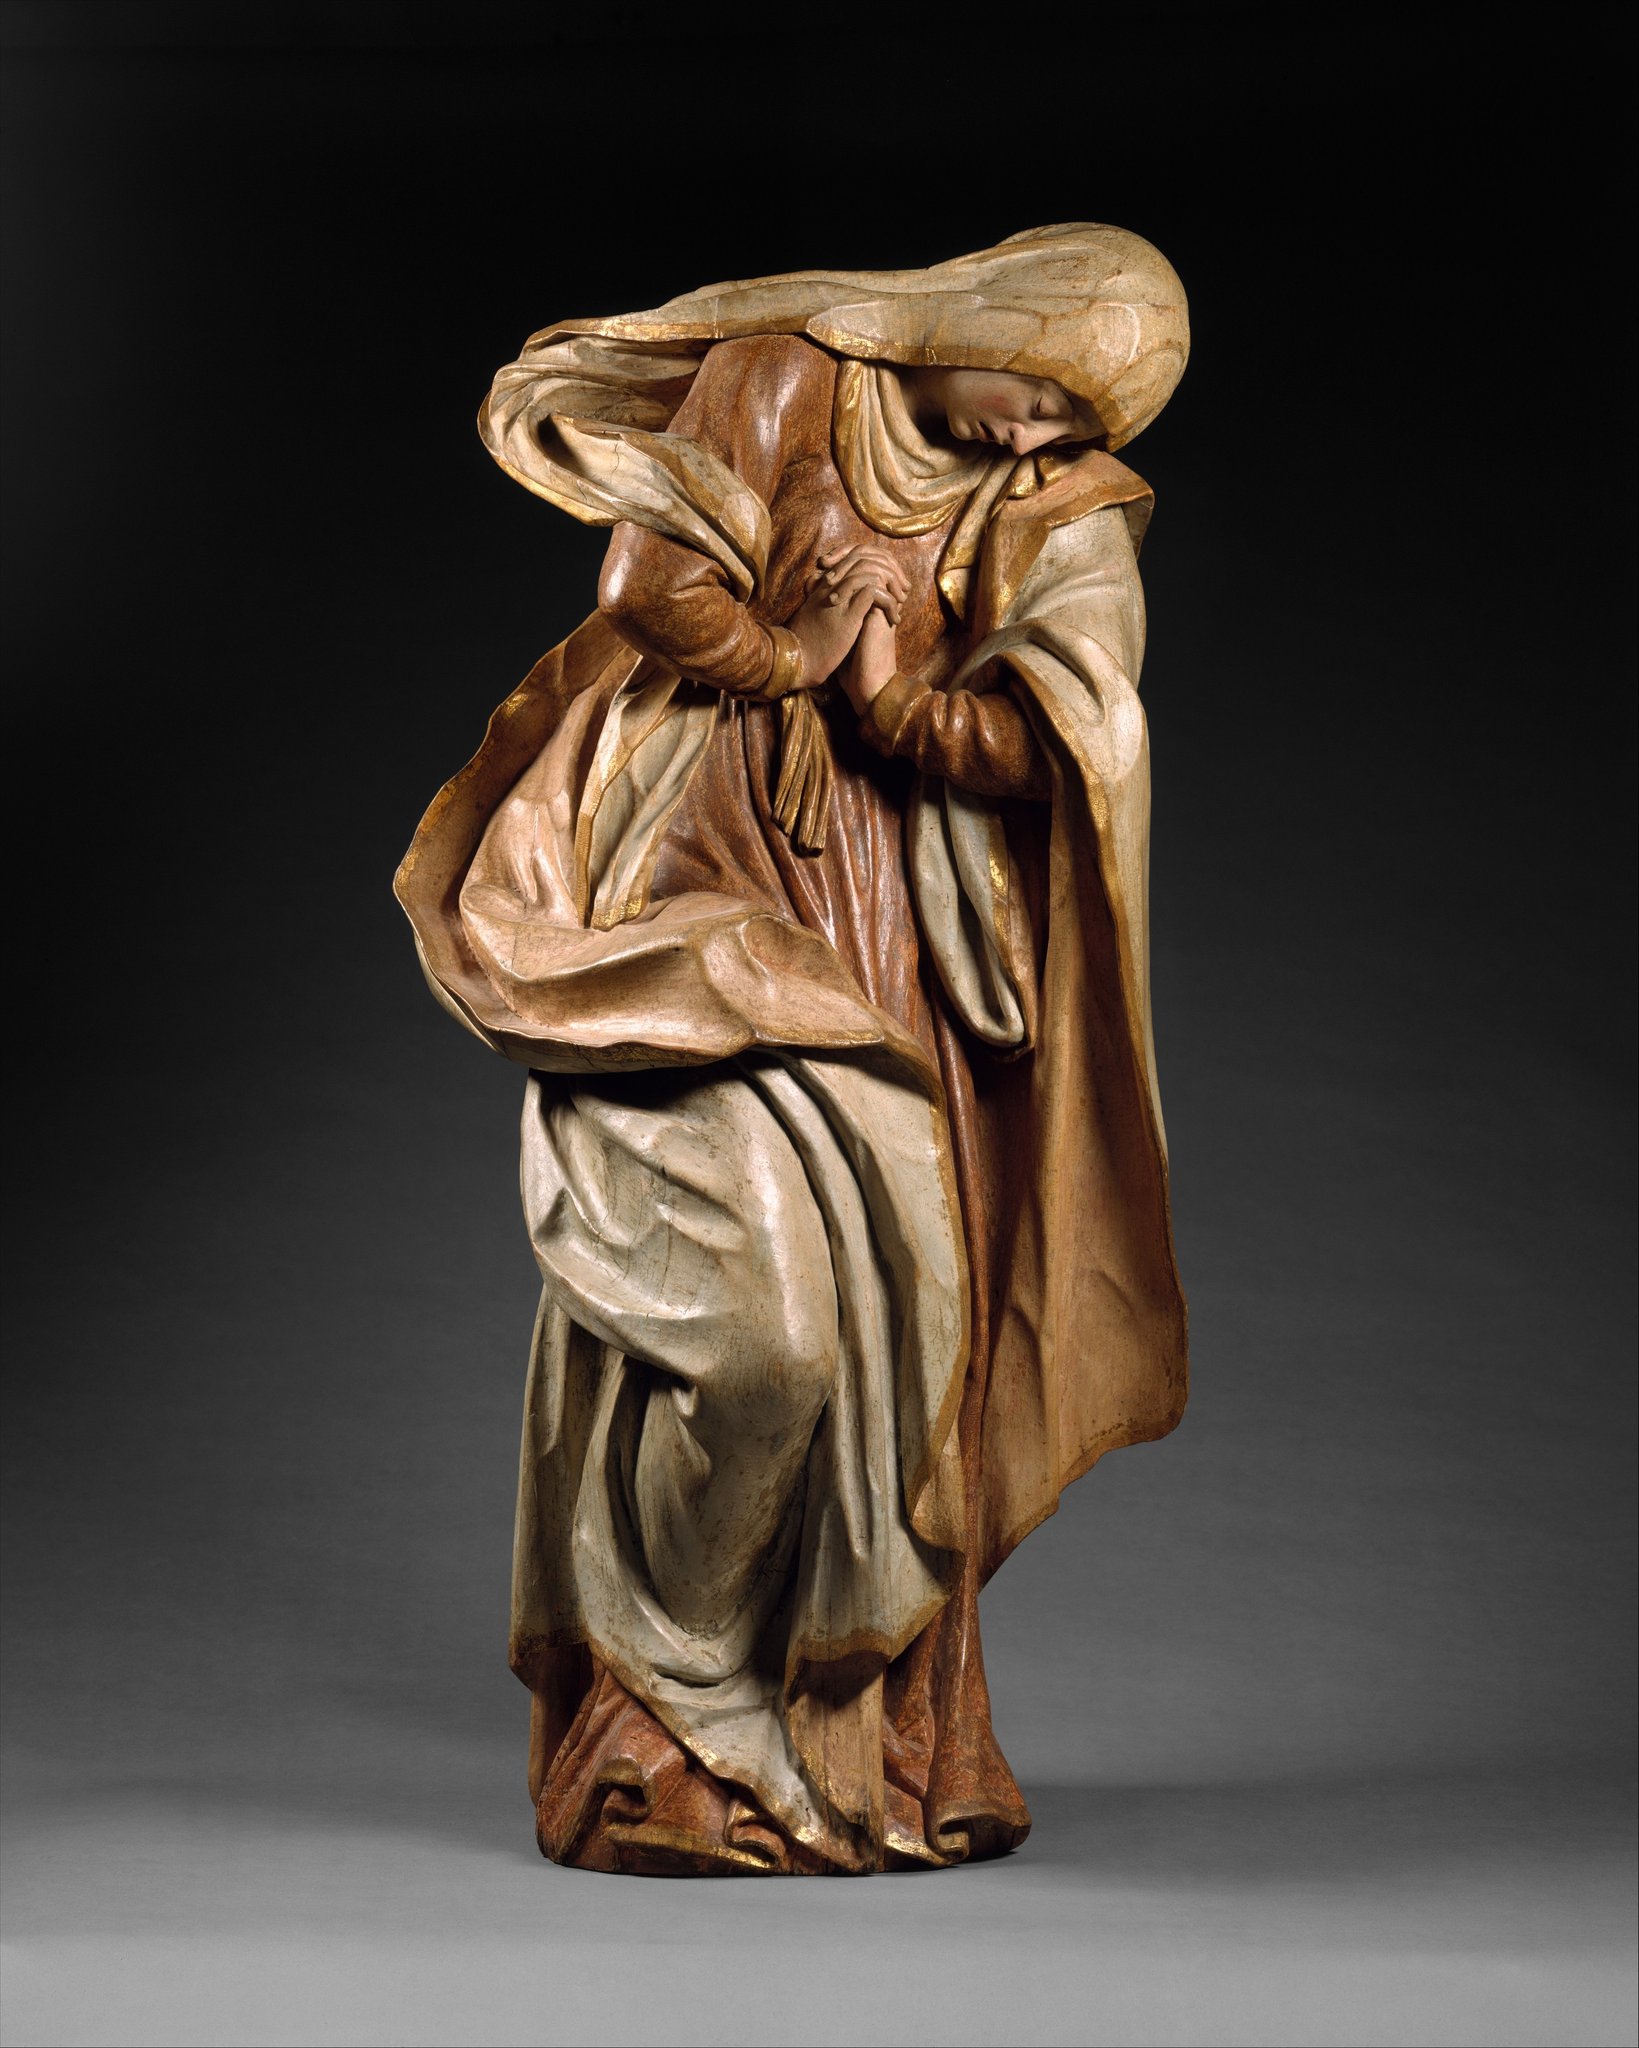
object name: statue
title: The Mourning Virgin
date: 1701-1733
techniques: gilding, polychrome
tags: sadness,virgin mary